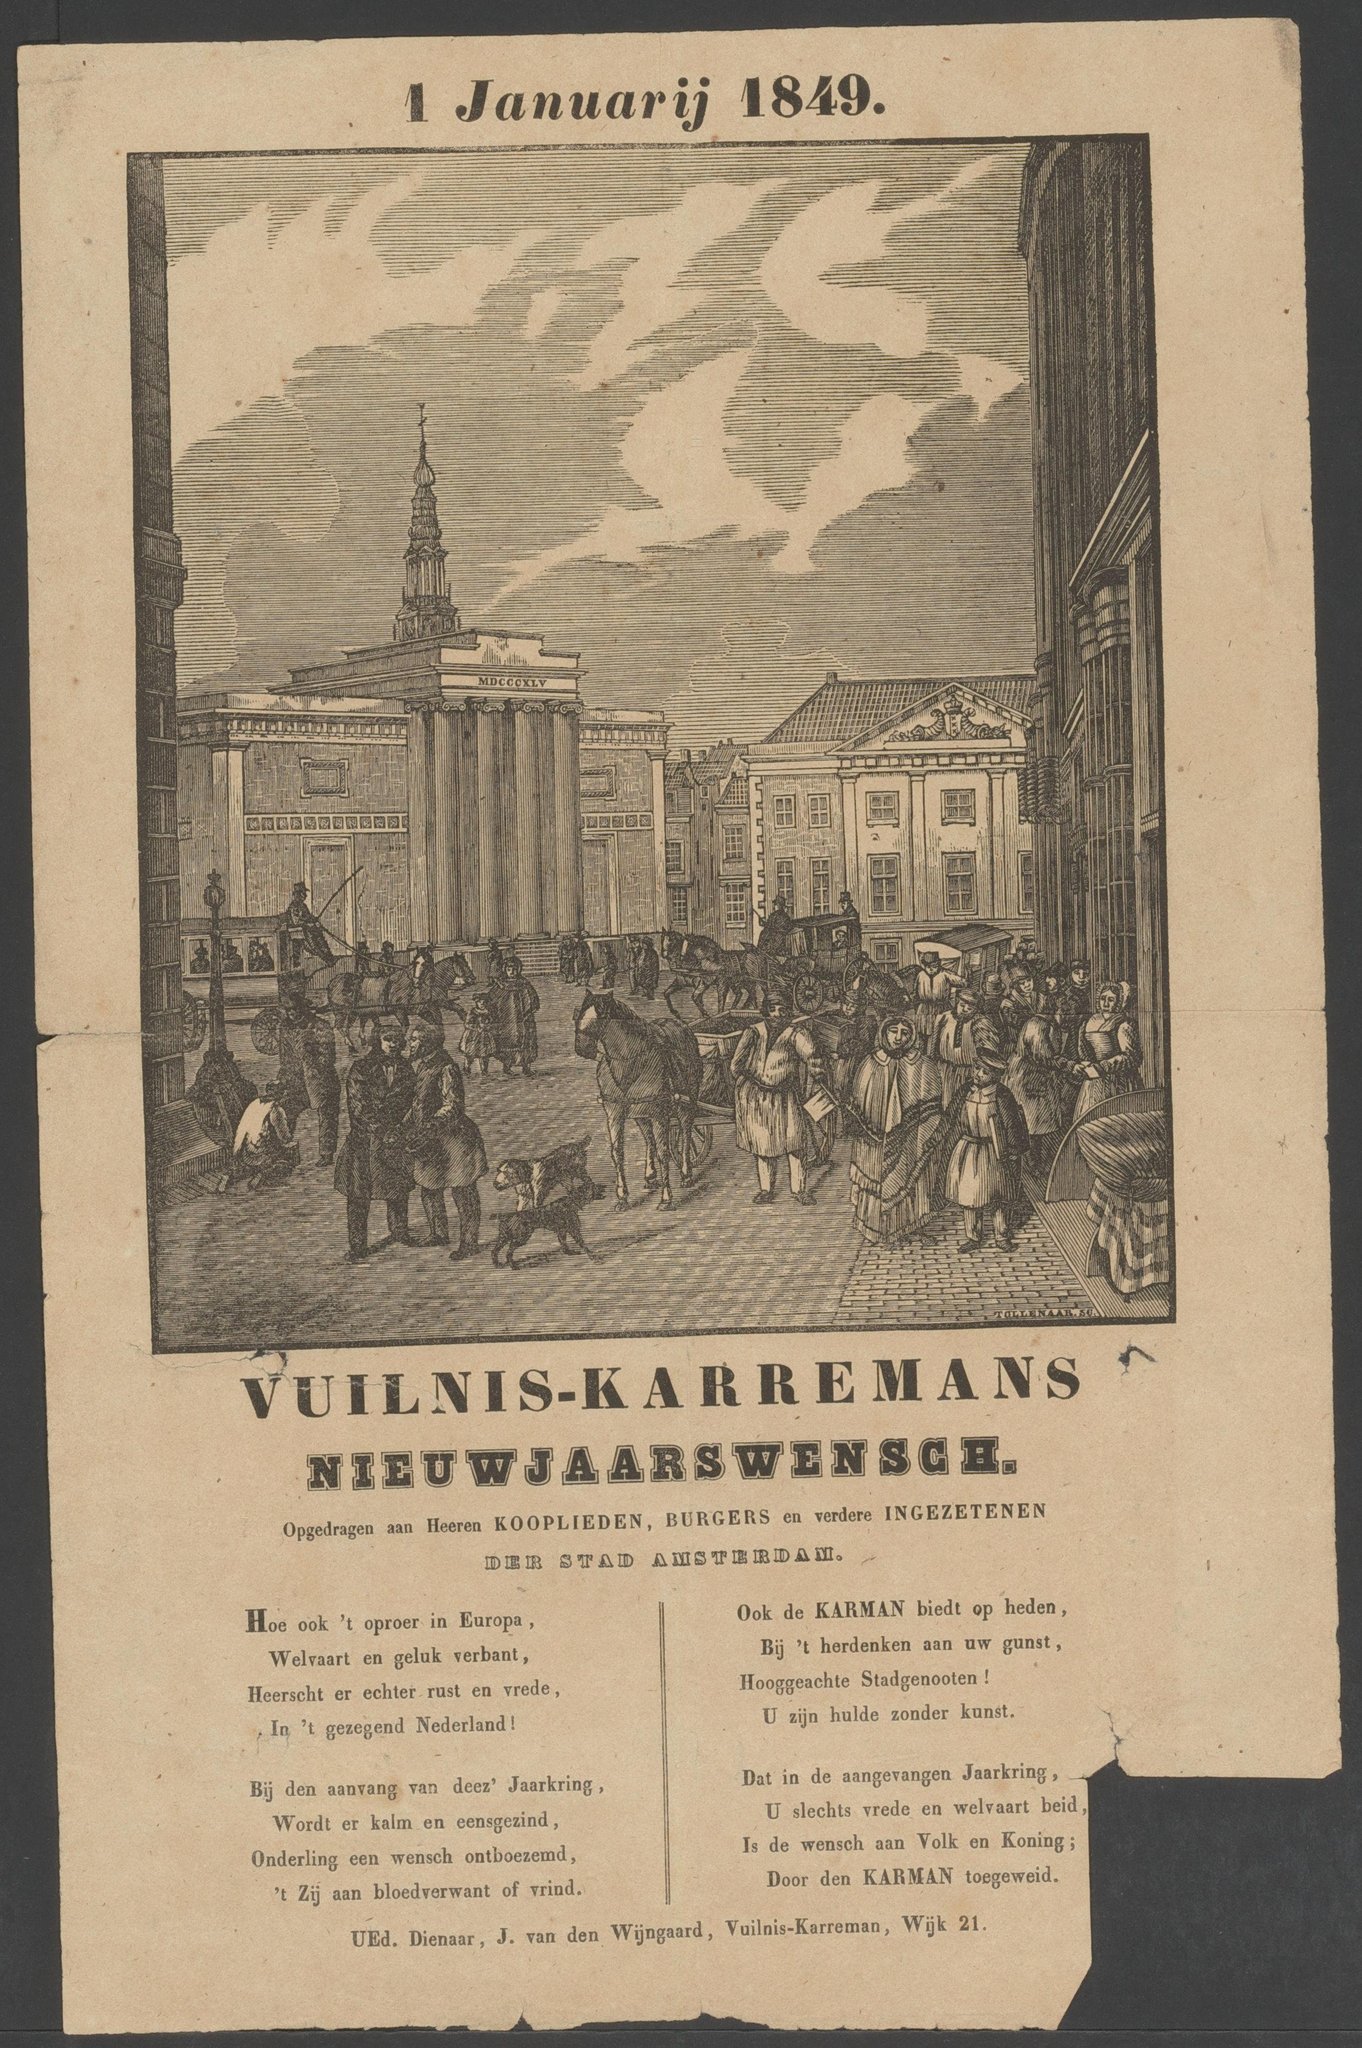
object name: new year card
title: Nieuwjaarrsprent van de vuilnismannen van Amsterdam voor het jaar 1849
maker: dirk wijbrand tollenaar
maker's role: print maker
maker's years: 1808-1858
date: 1848-1849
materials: paper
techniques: letterpress printing, engraving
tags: street, garbage collection, amsterdam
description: Nieuwjaarrsprent van de vuilnismannen van Amsterdam voor het jaar 1849. Gezicht op de Dam met de Beurs van Zocher en het Commandantshuis te Amsterdam. Tussen het publiek de vuilnismannen met hun kar. Met gedicht in twee kolommen. Van de vuilniskarman in de wijk no. 21: J. van den Wijngaard. Onderwerpsrubrieken binnen de Atlas Zeden en Gewoonten: Zeden en gewoonten in engeren zin, Volksleven, Volksbladen, Nieuwjaars- en Kerstwenschen, Amsterdam.